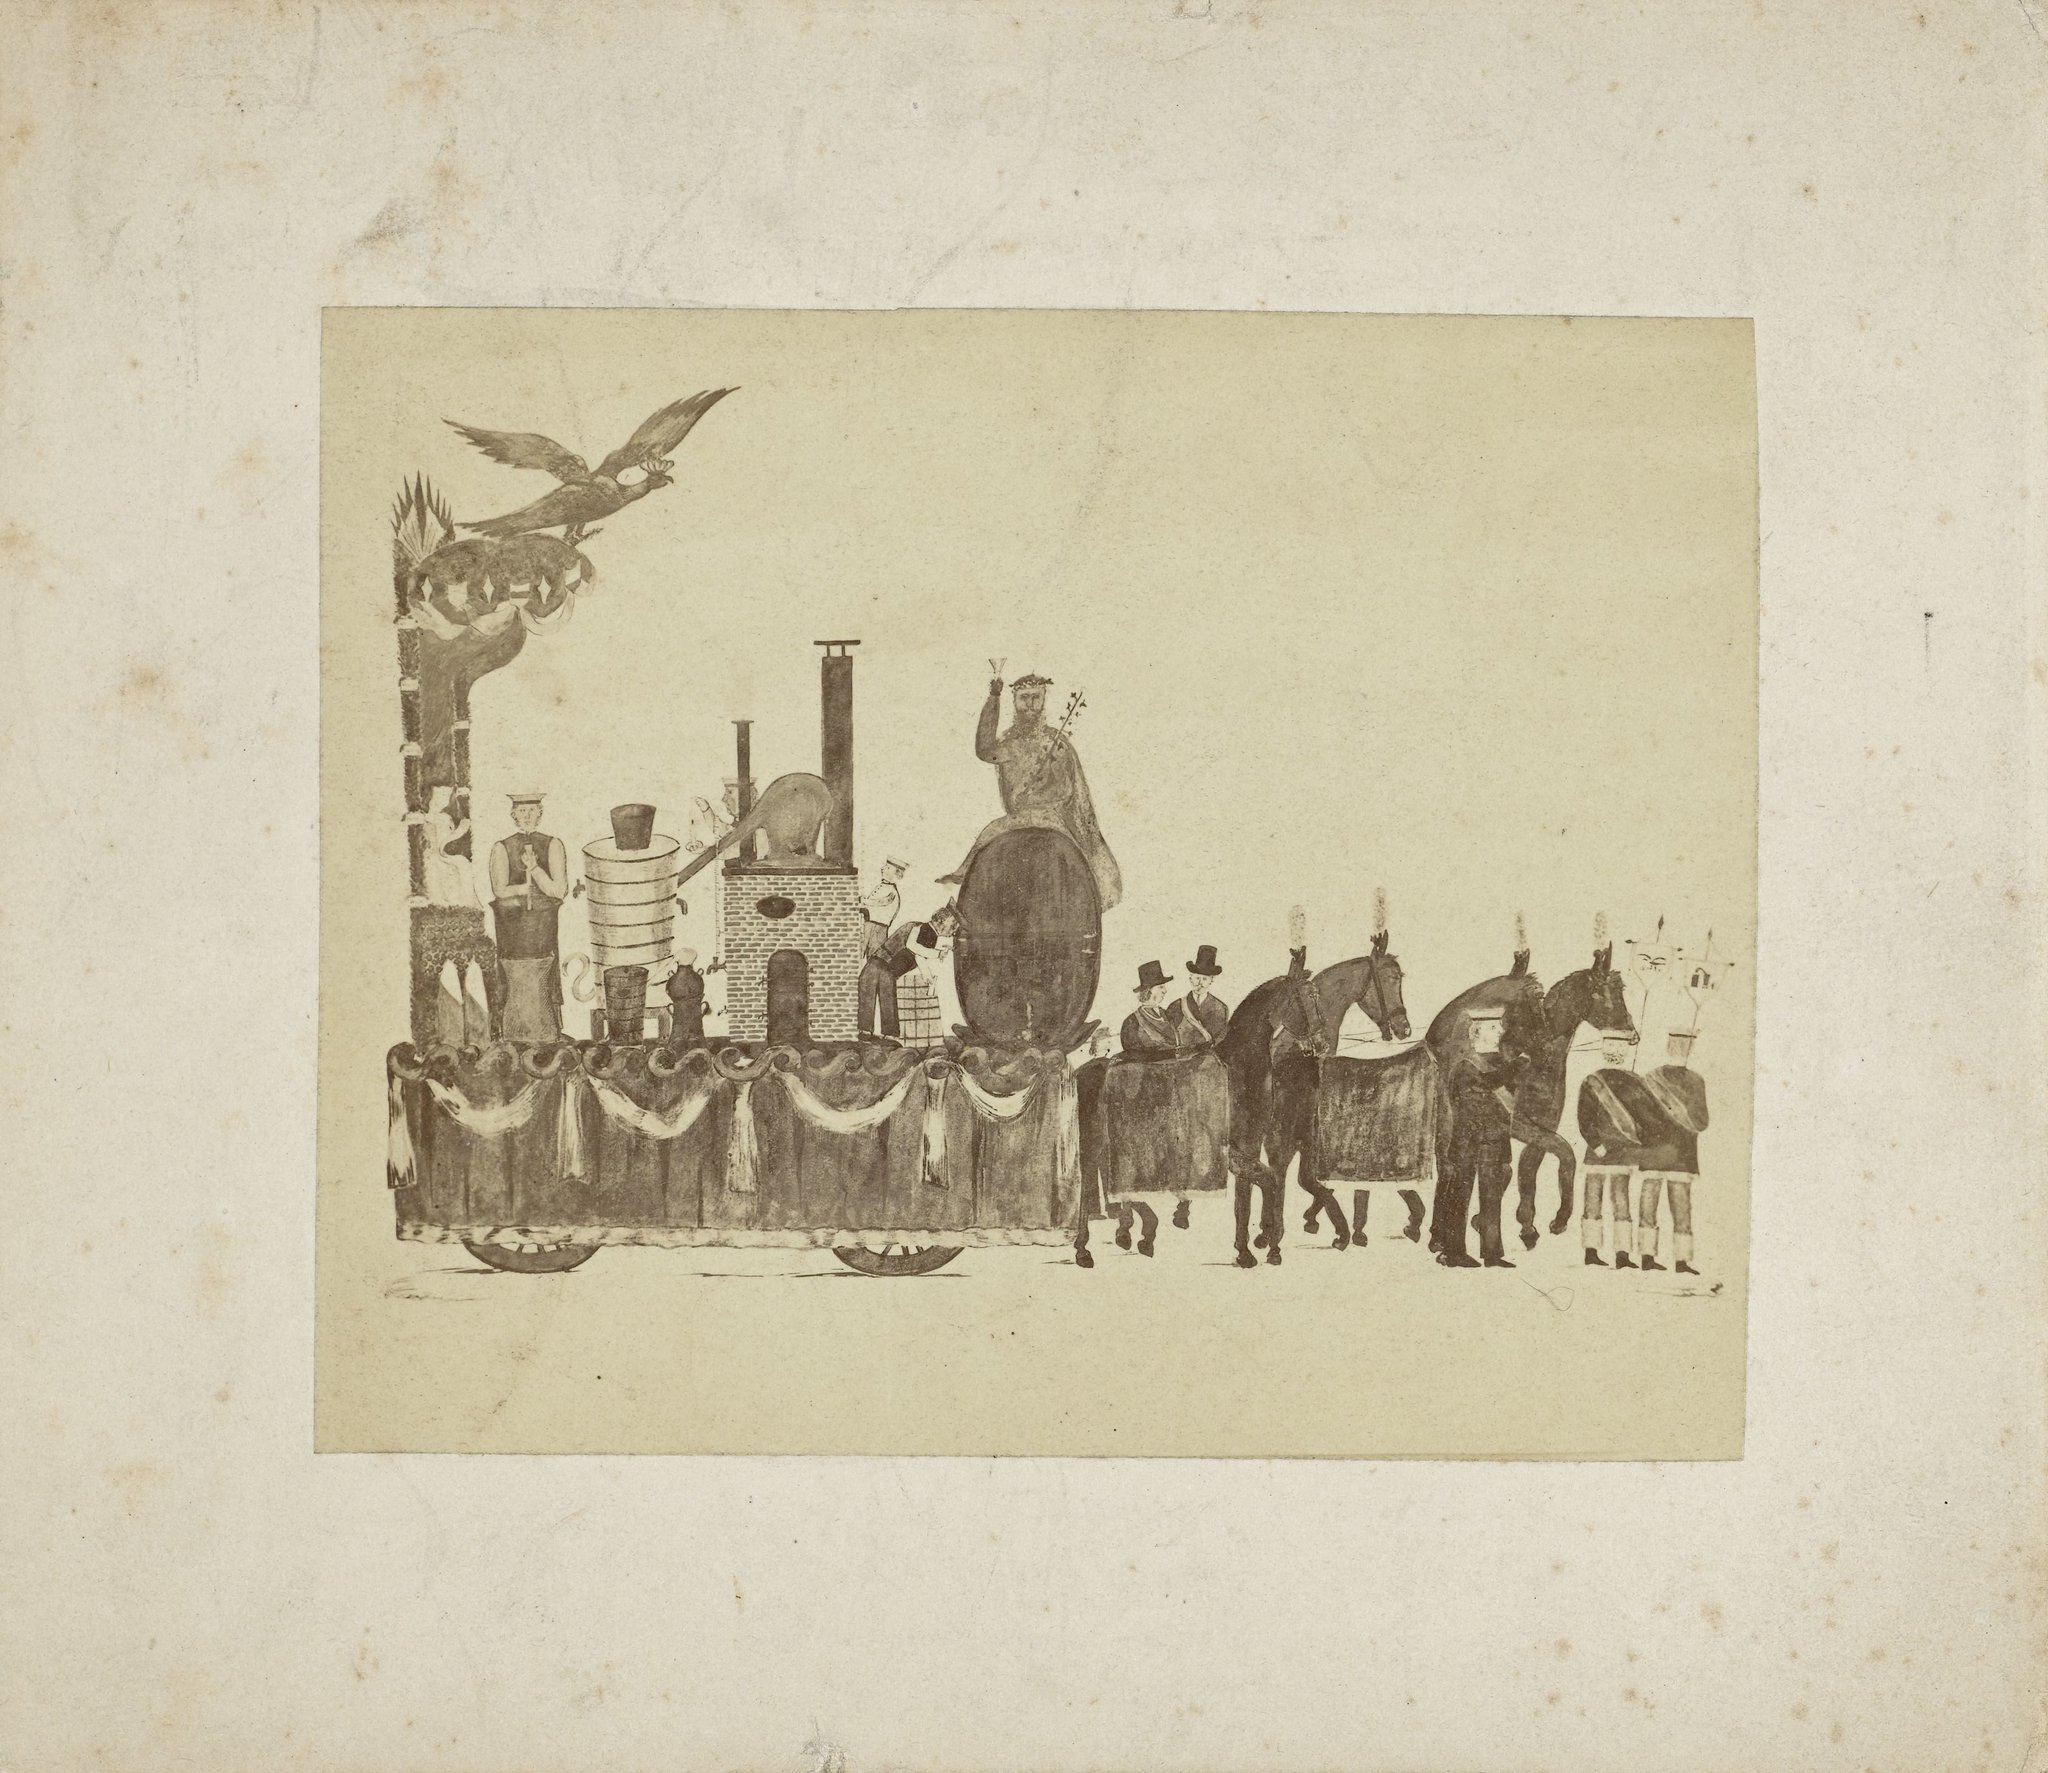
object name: photograph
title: Fotoreproductie van een tekening van een praalwagen met paarden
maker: Anonymous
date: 1851-1890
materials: cardboard, paper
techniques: albumen print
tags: public festivities